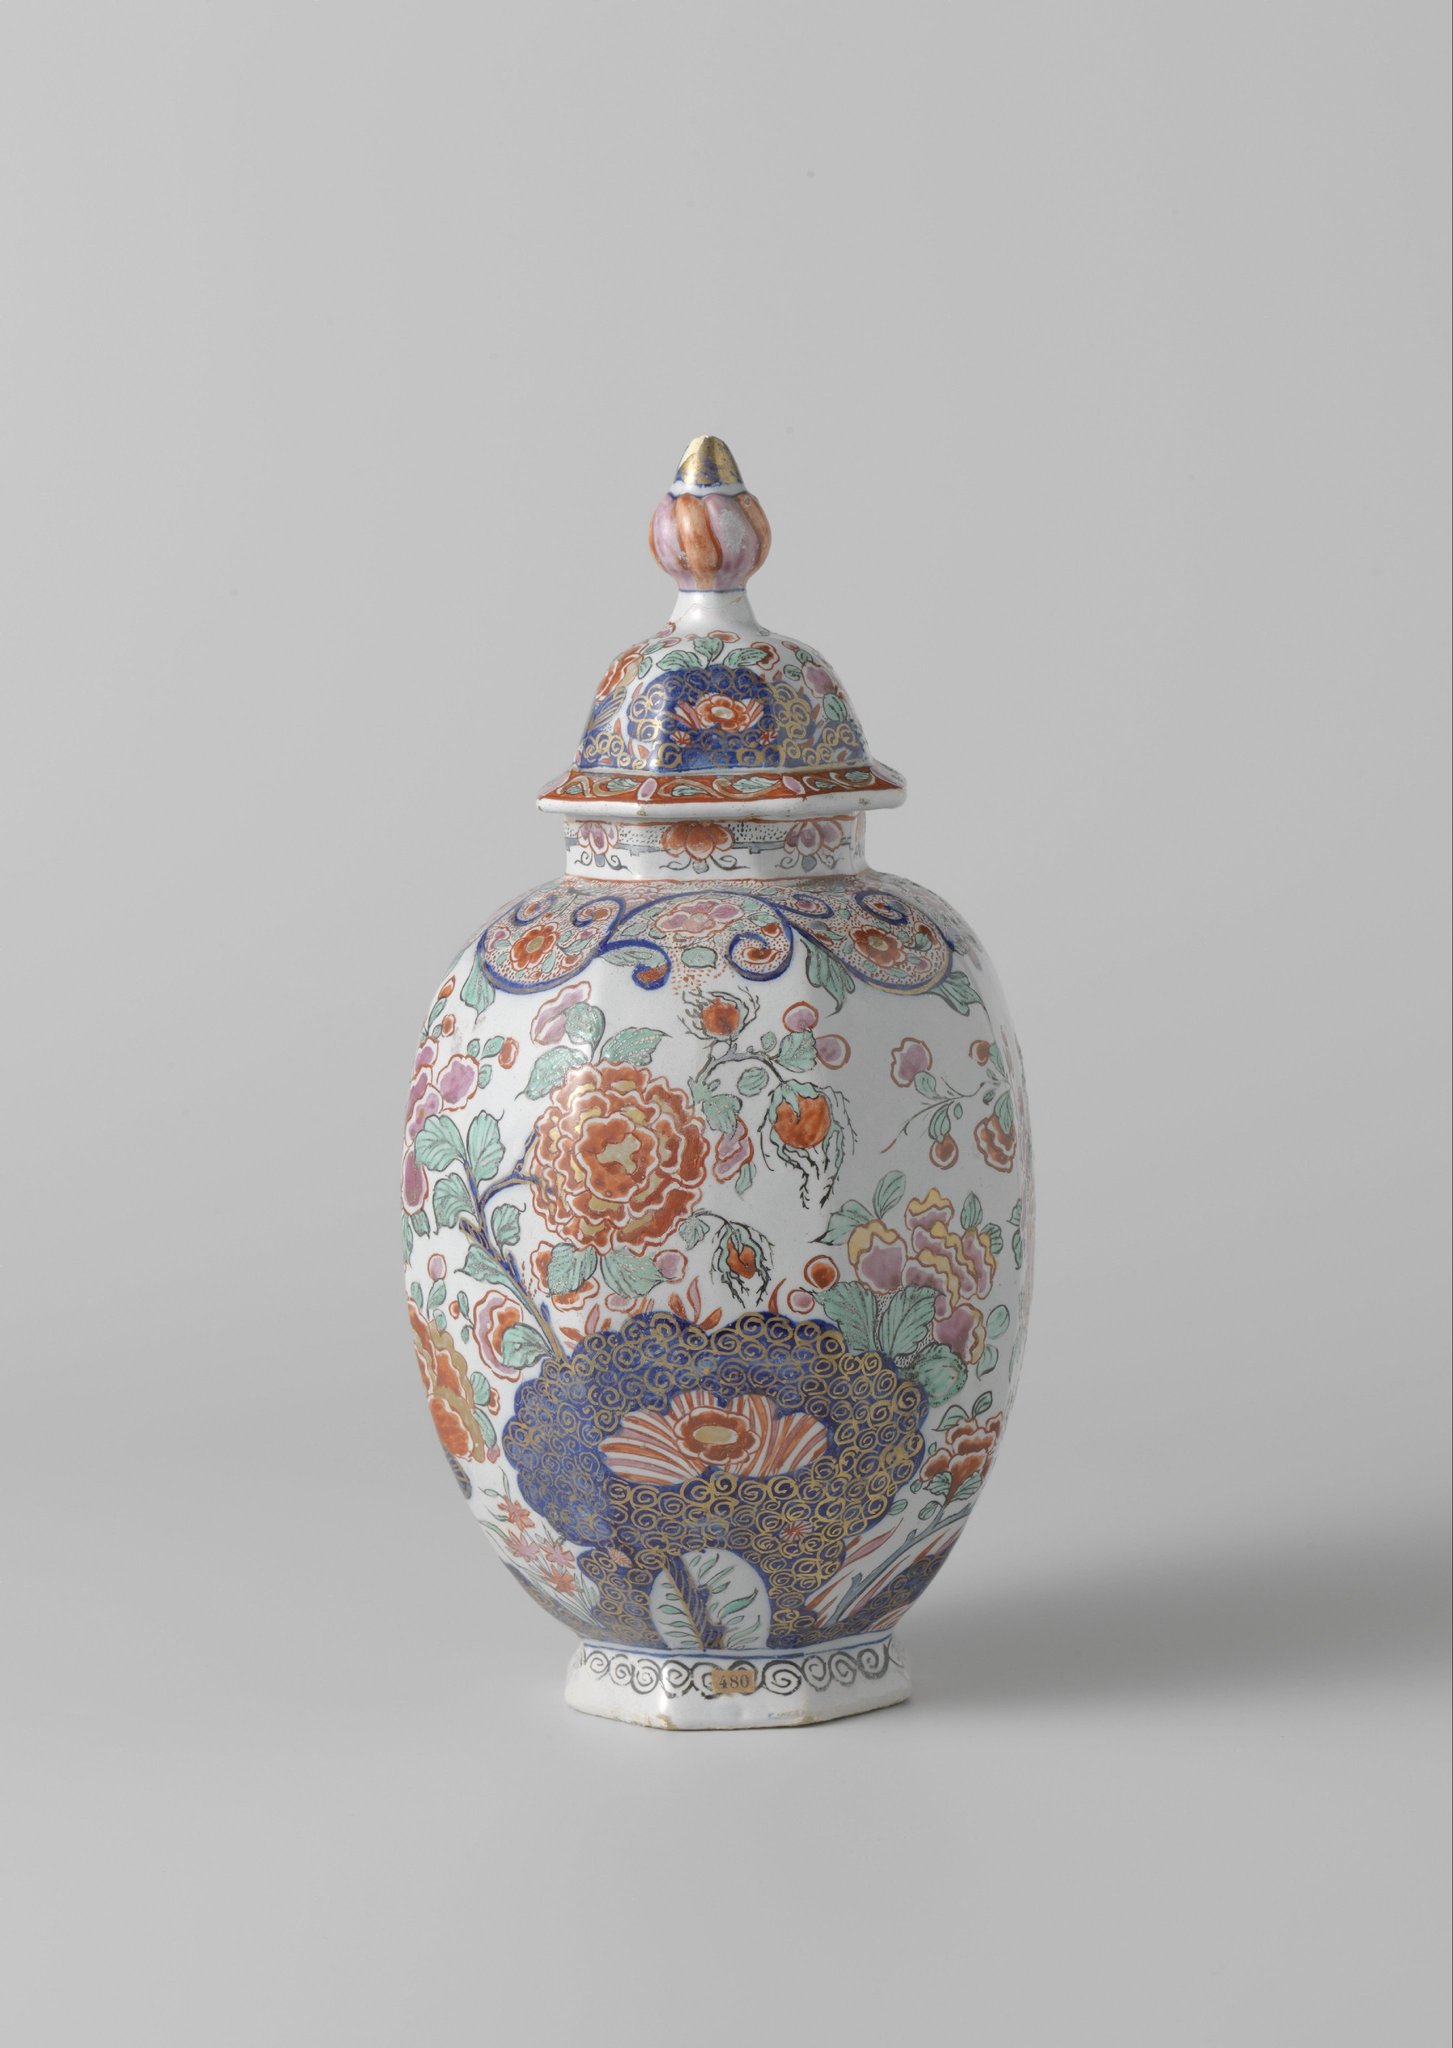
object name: covered jar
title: Pot met deksel van veelkleurig beschilderde faïence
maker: Anonymous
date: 1730-1760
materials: faience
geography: delft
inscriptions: collector's mark: ‘Collection JF Loudon’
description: Pot met deksel van faïence. Veelkleurig beschilderd met bloemdecoraties. De pot is een onderdeel van een kaststel.